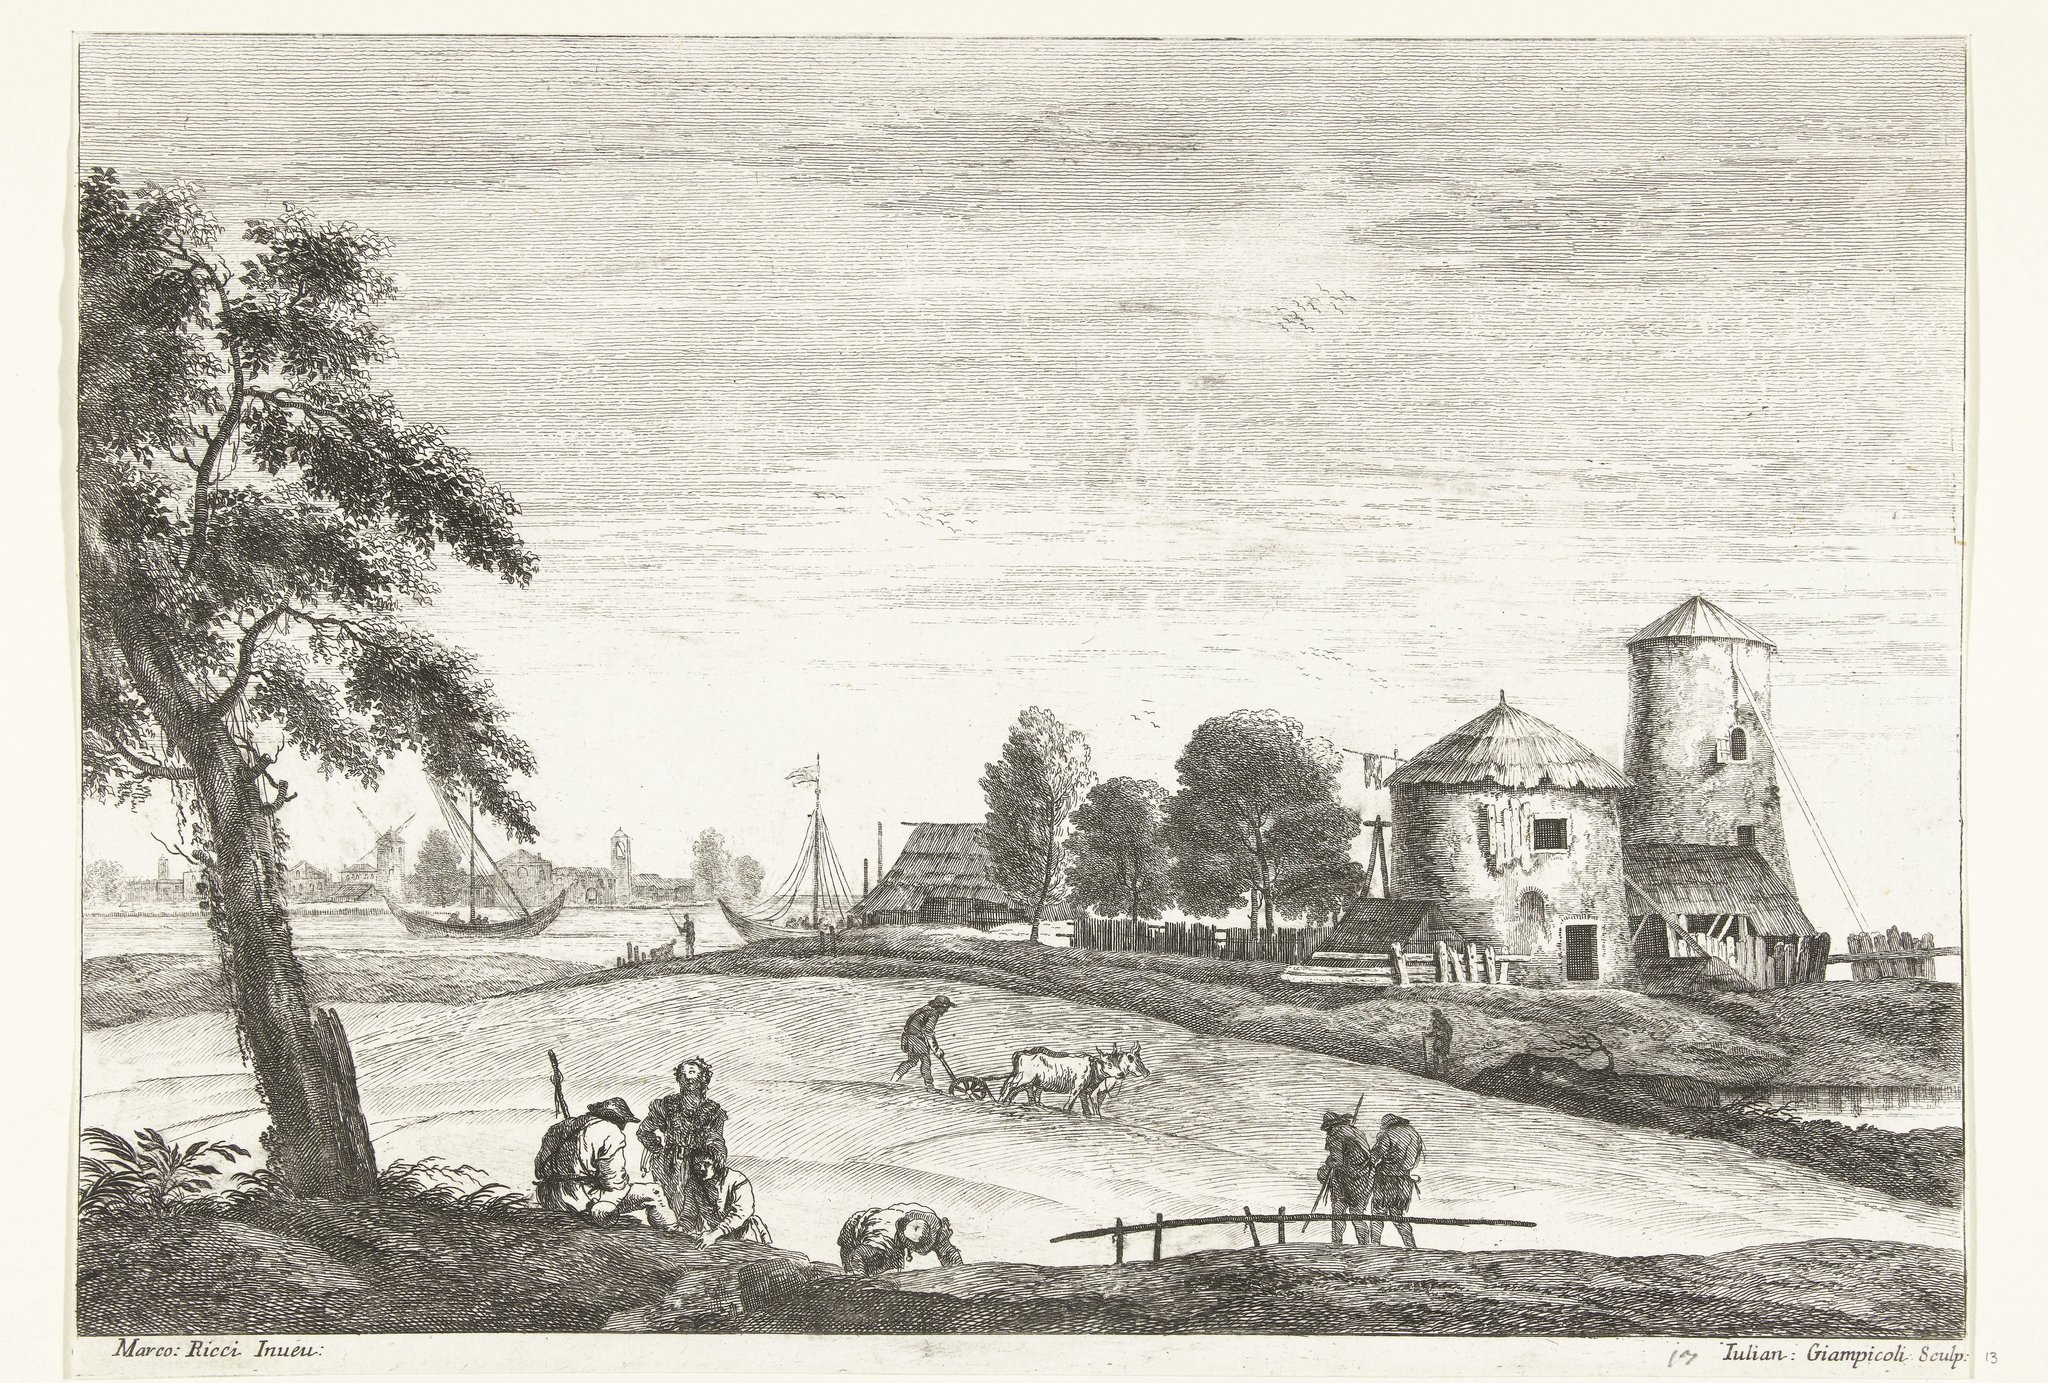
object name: print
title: Italiaanse landschappen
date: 1739-1740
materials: paper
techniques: etching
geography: venice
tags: farm or solitary house in landscape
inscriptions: collector's mark: Lugt 2228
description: Prent uit eerste serie van achttien prenten met Italiaanse landschappen naar ontwerp van Marco Ricci en titelprent (zie RP-P-1952-20) opgedragen aan consul Joseph Smith. Het serienummer 13 is van dit blad afgesneden.